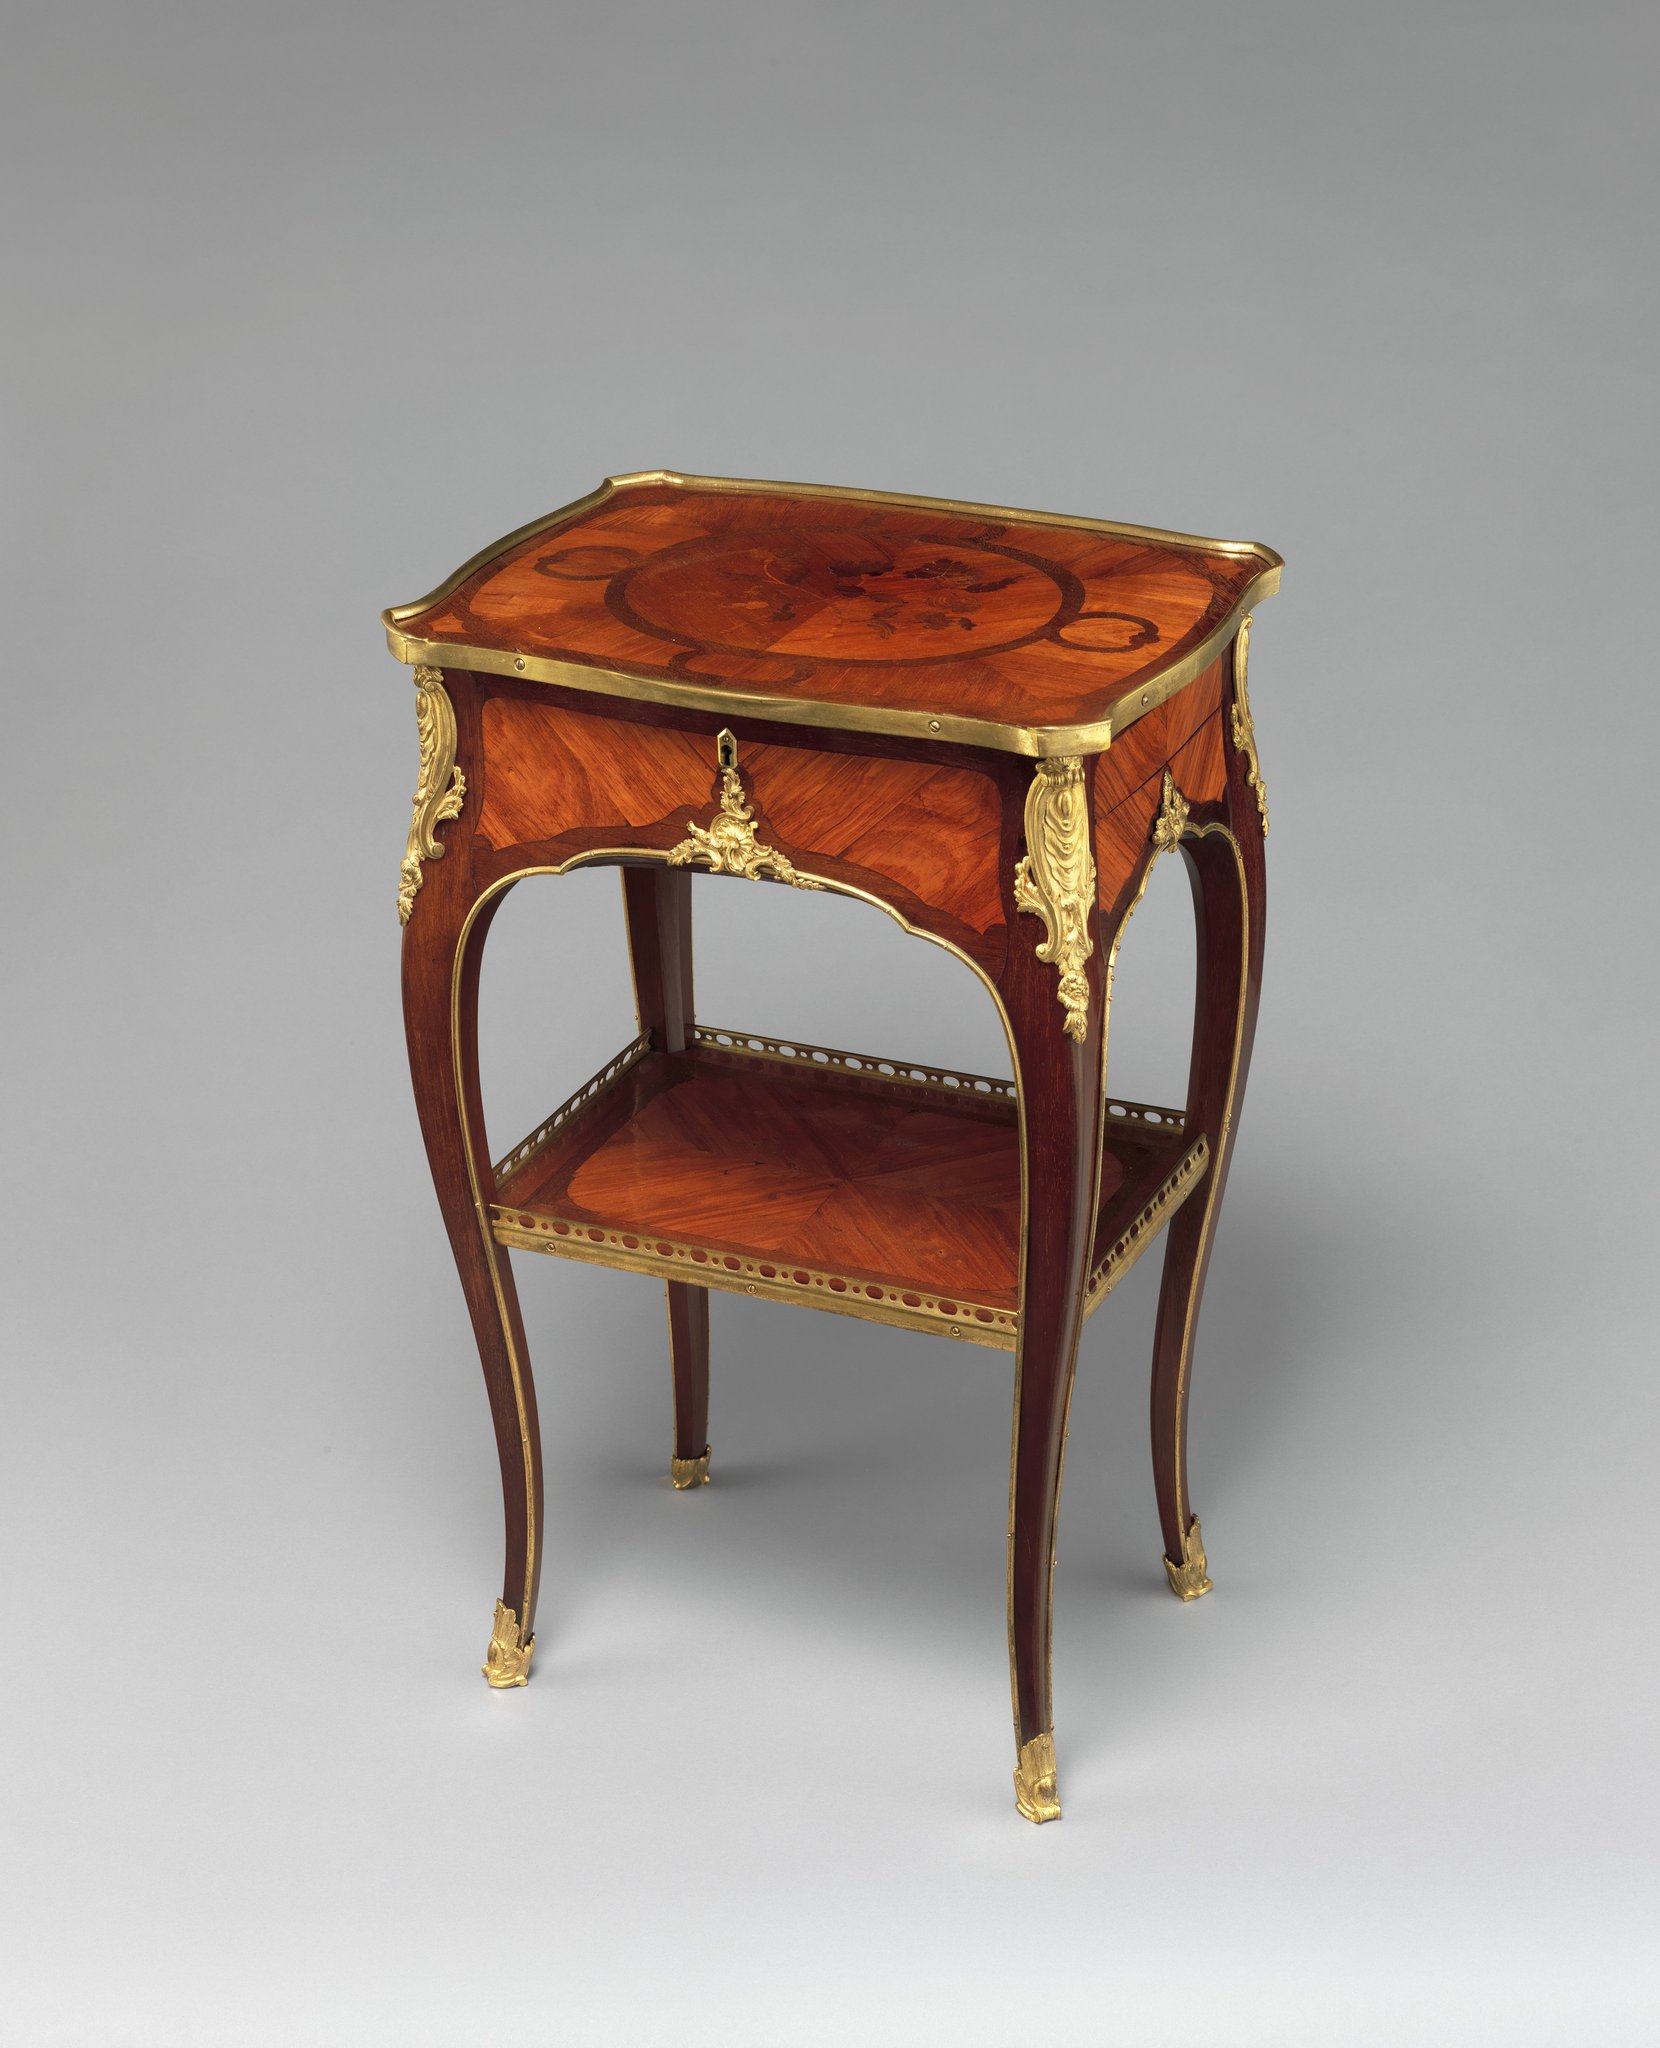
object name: work and writing table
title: Work and writing table (table en chiffonière)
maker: bernard ii van risenburgh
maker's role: maker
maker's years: 1696-1767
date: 1760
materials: gilt bronze, metal, wood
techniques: silvered, veneering